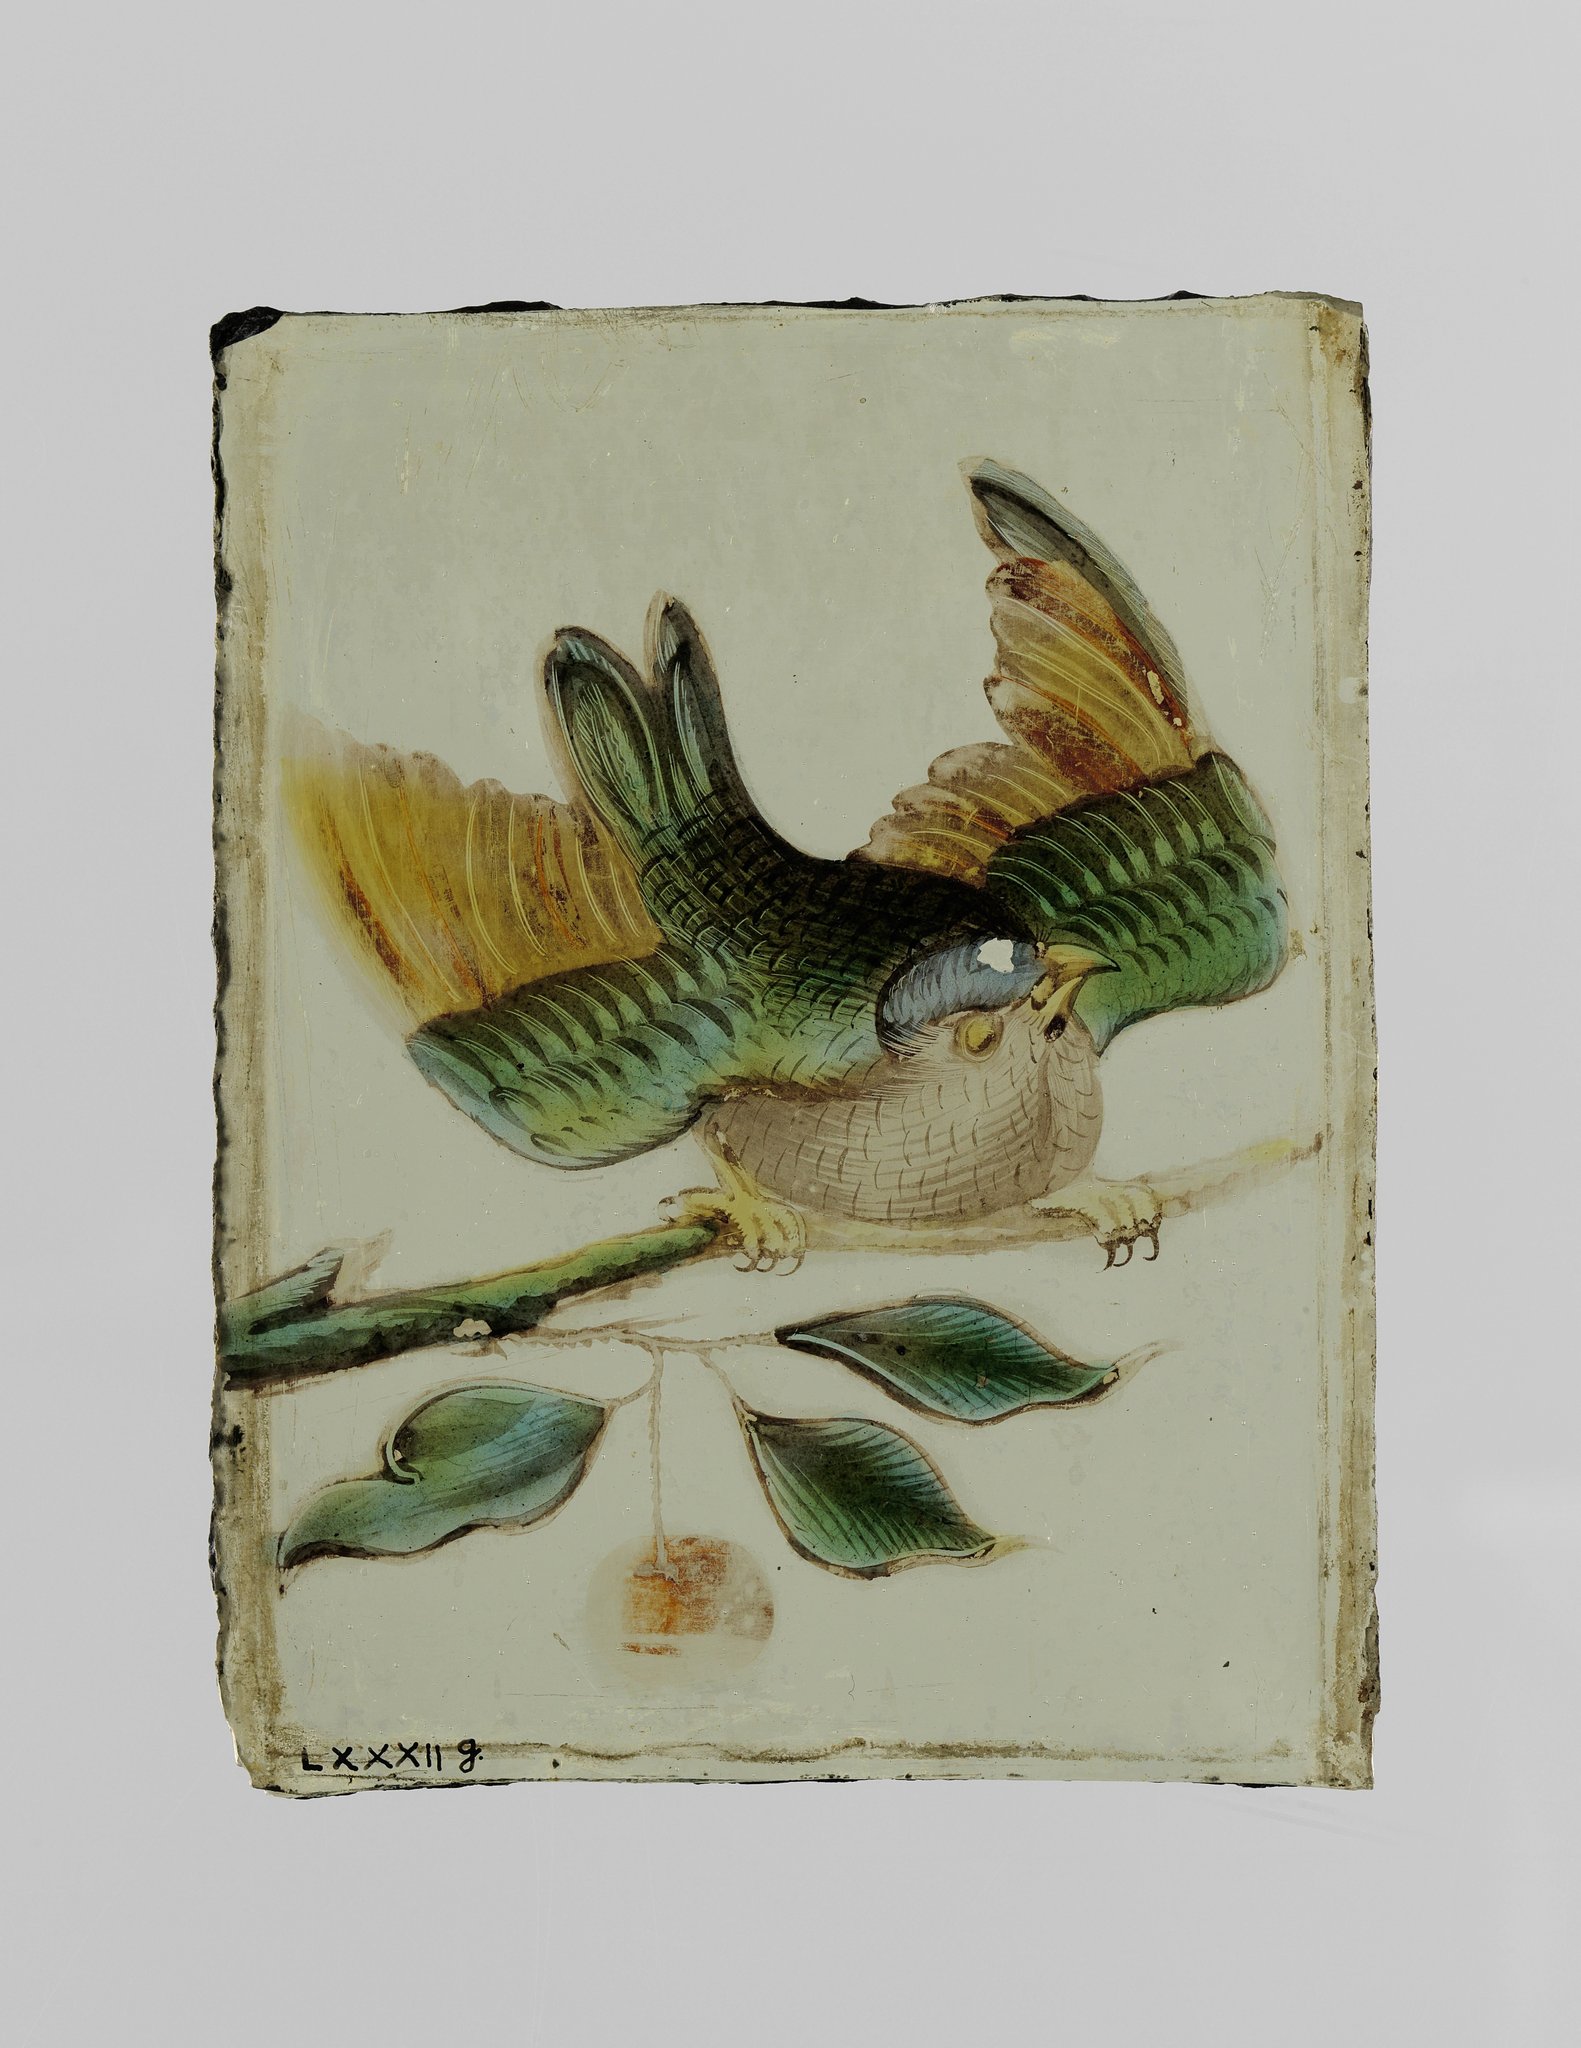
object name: light window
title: Ruit met een vogel op een tak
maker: Anonymous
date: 1650-1675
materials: glass, lead, pigment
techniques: enamel painting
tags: birds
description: Een ruit met emailschildering van een vogel in blauw, zilvergeel en grisaille.